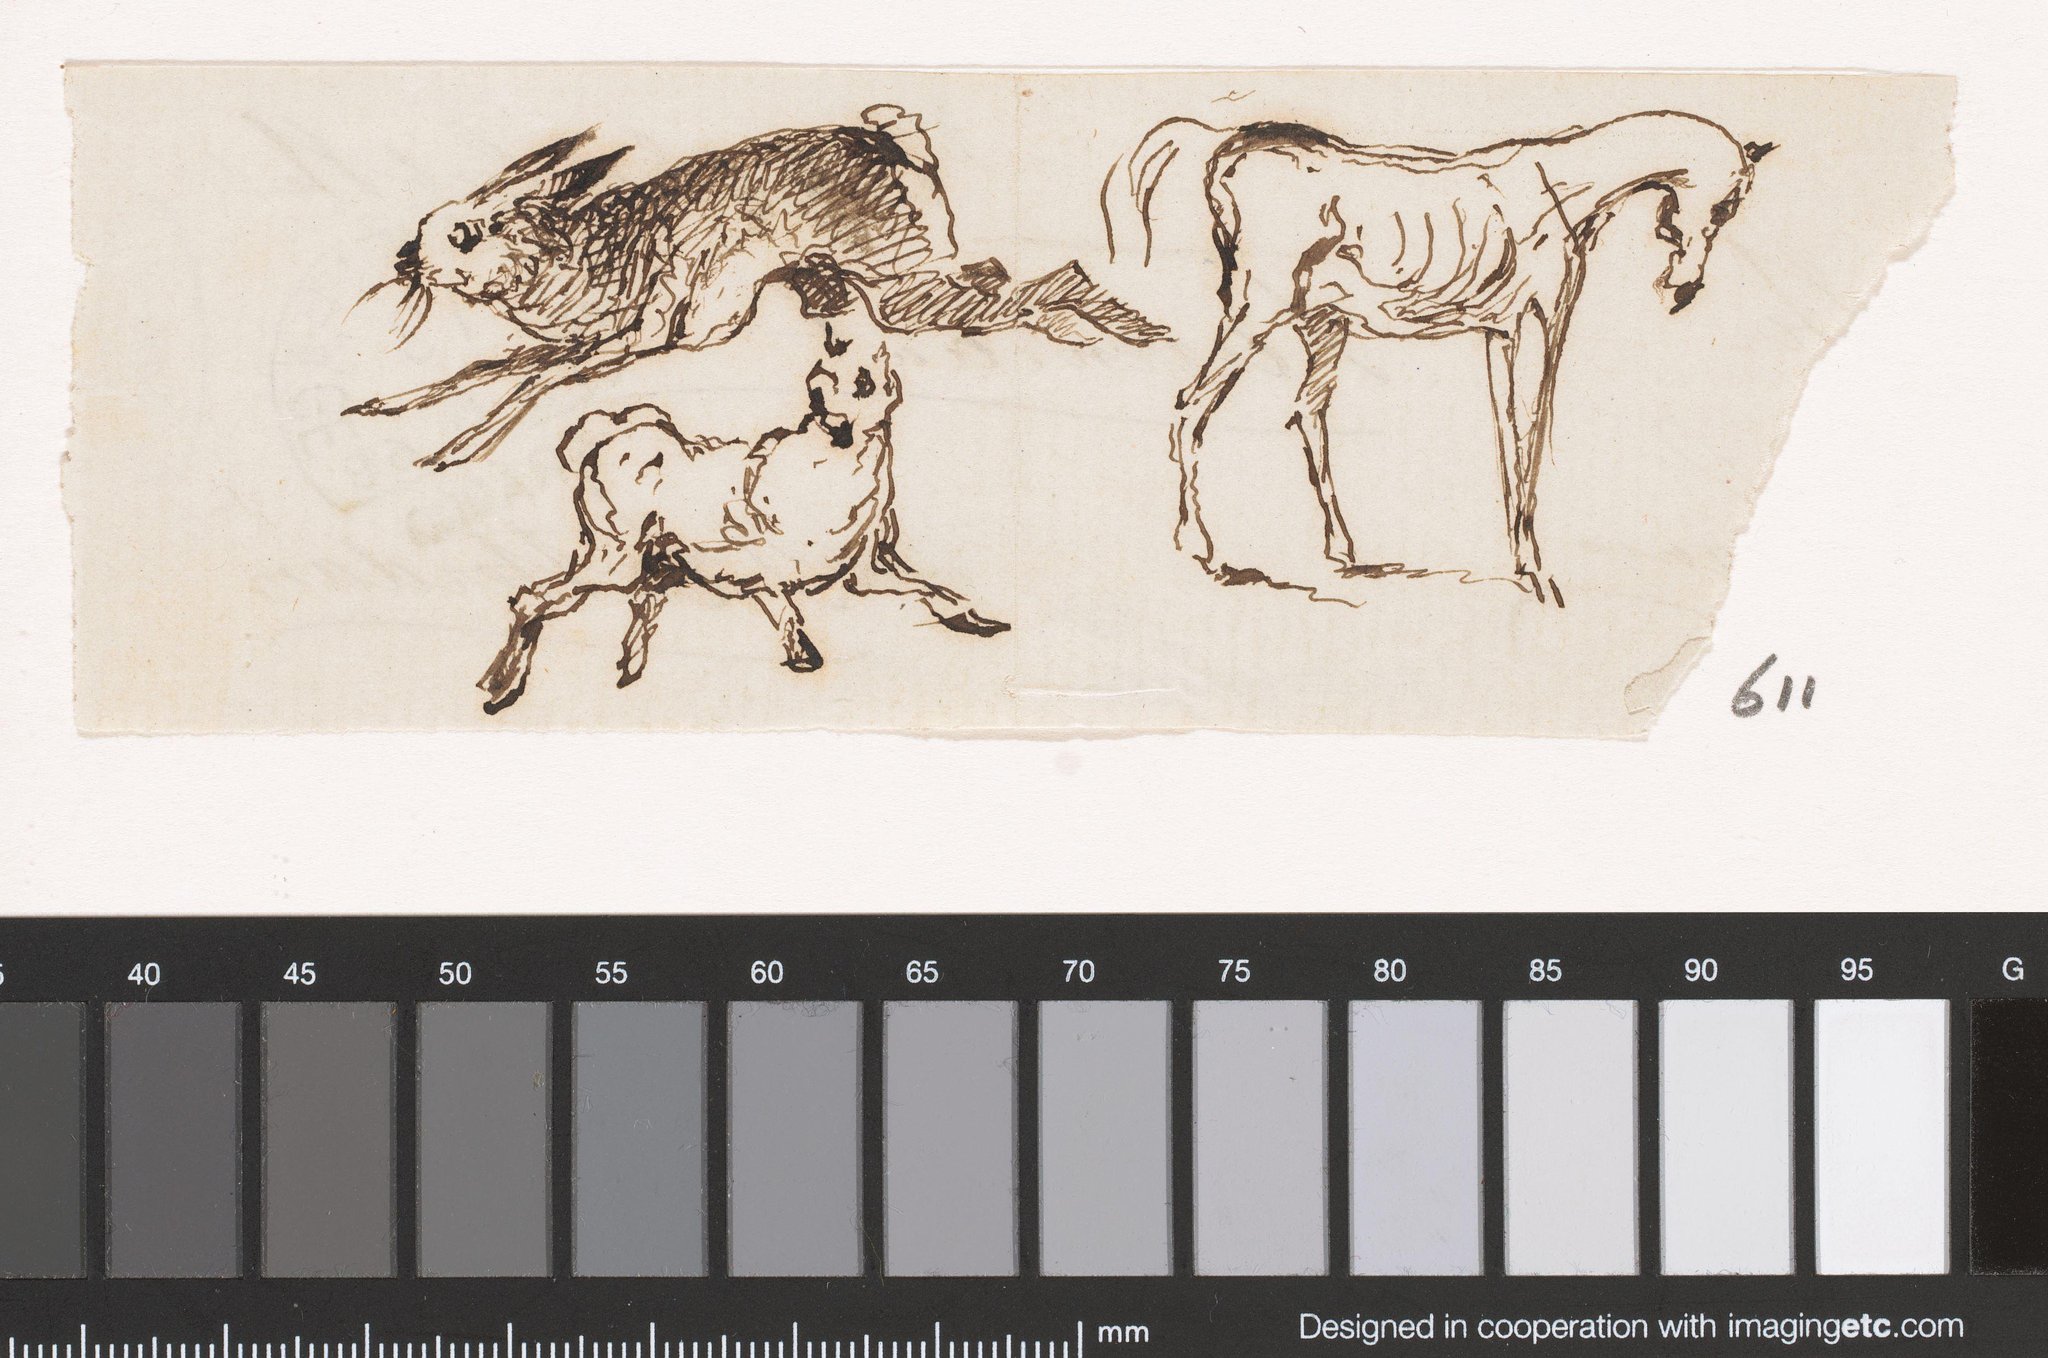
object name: drawing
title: Twee hazen en een paard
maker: johannes tavenraat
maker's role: draughtsman, painter, print maker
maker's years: 1809-1881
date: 1868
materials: ink, paper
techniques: pen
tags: rodents: hare, horse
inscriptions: collector's mark: Lugt 2228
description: Twee hazen en een paard. Getekend op de achterzijde van een deel van een envelop gericht aan Tavenraat, met poststempel 1868.